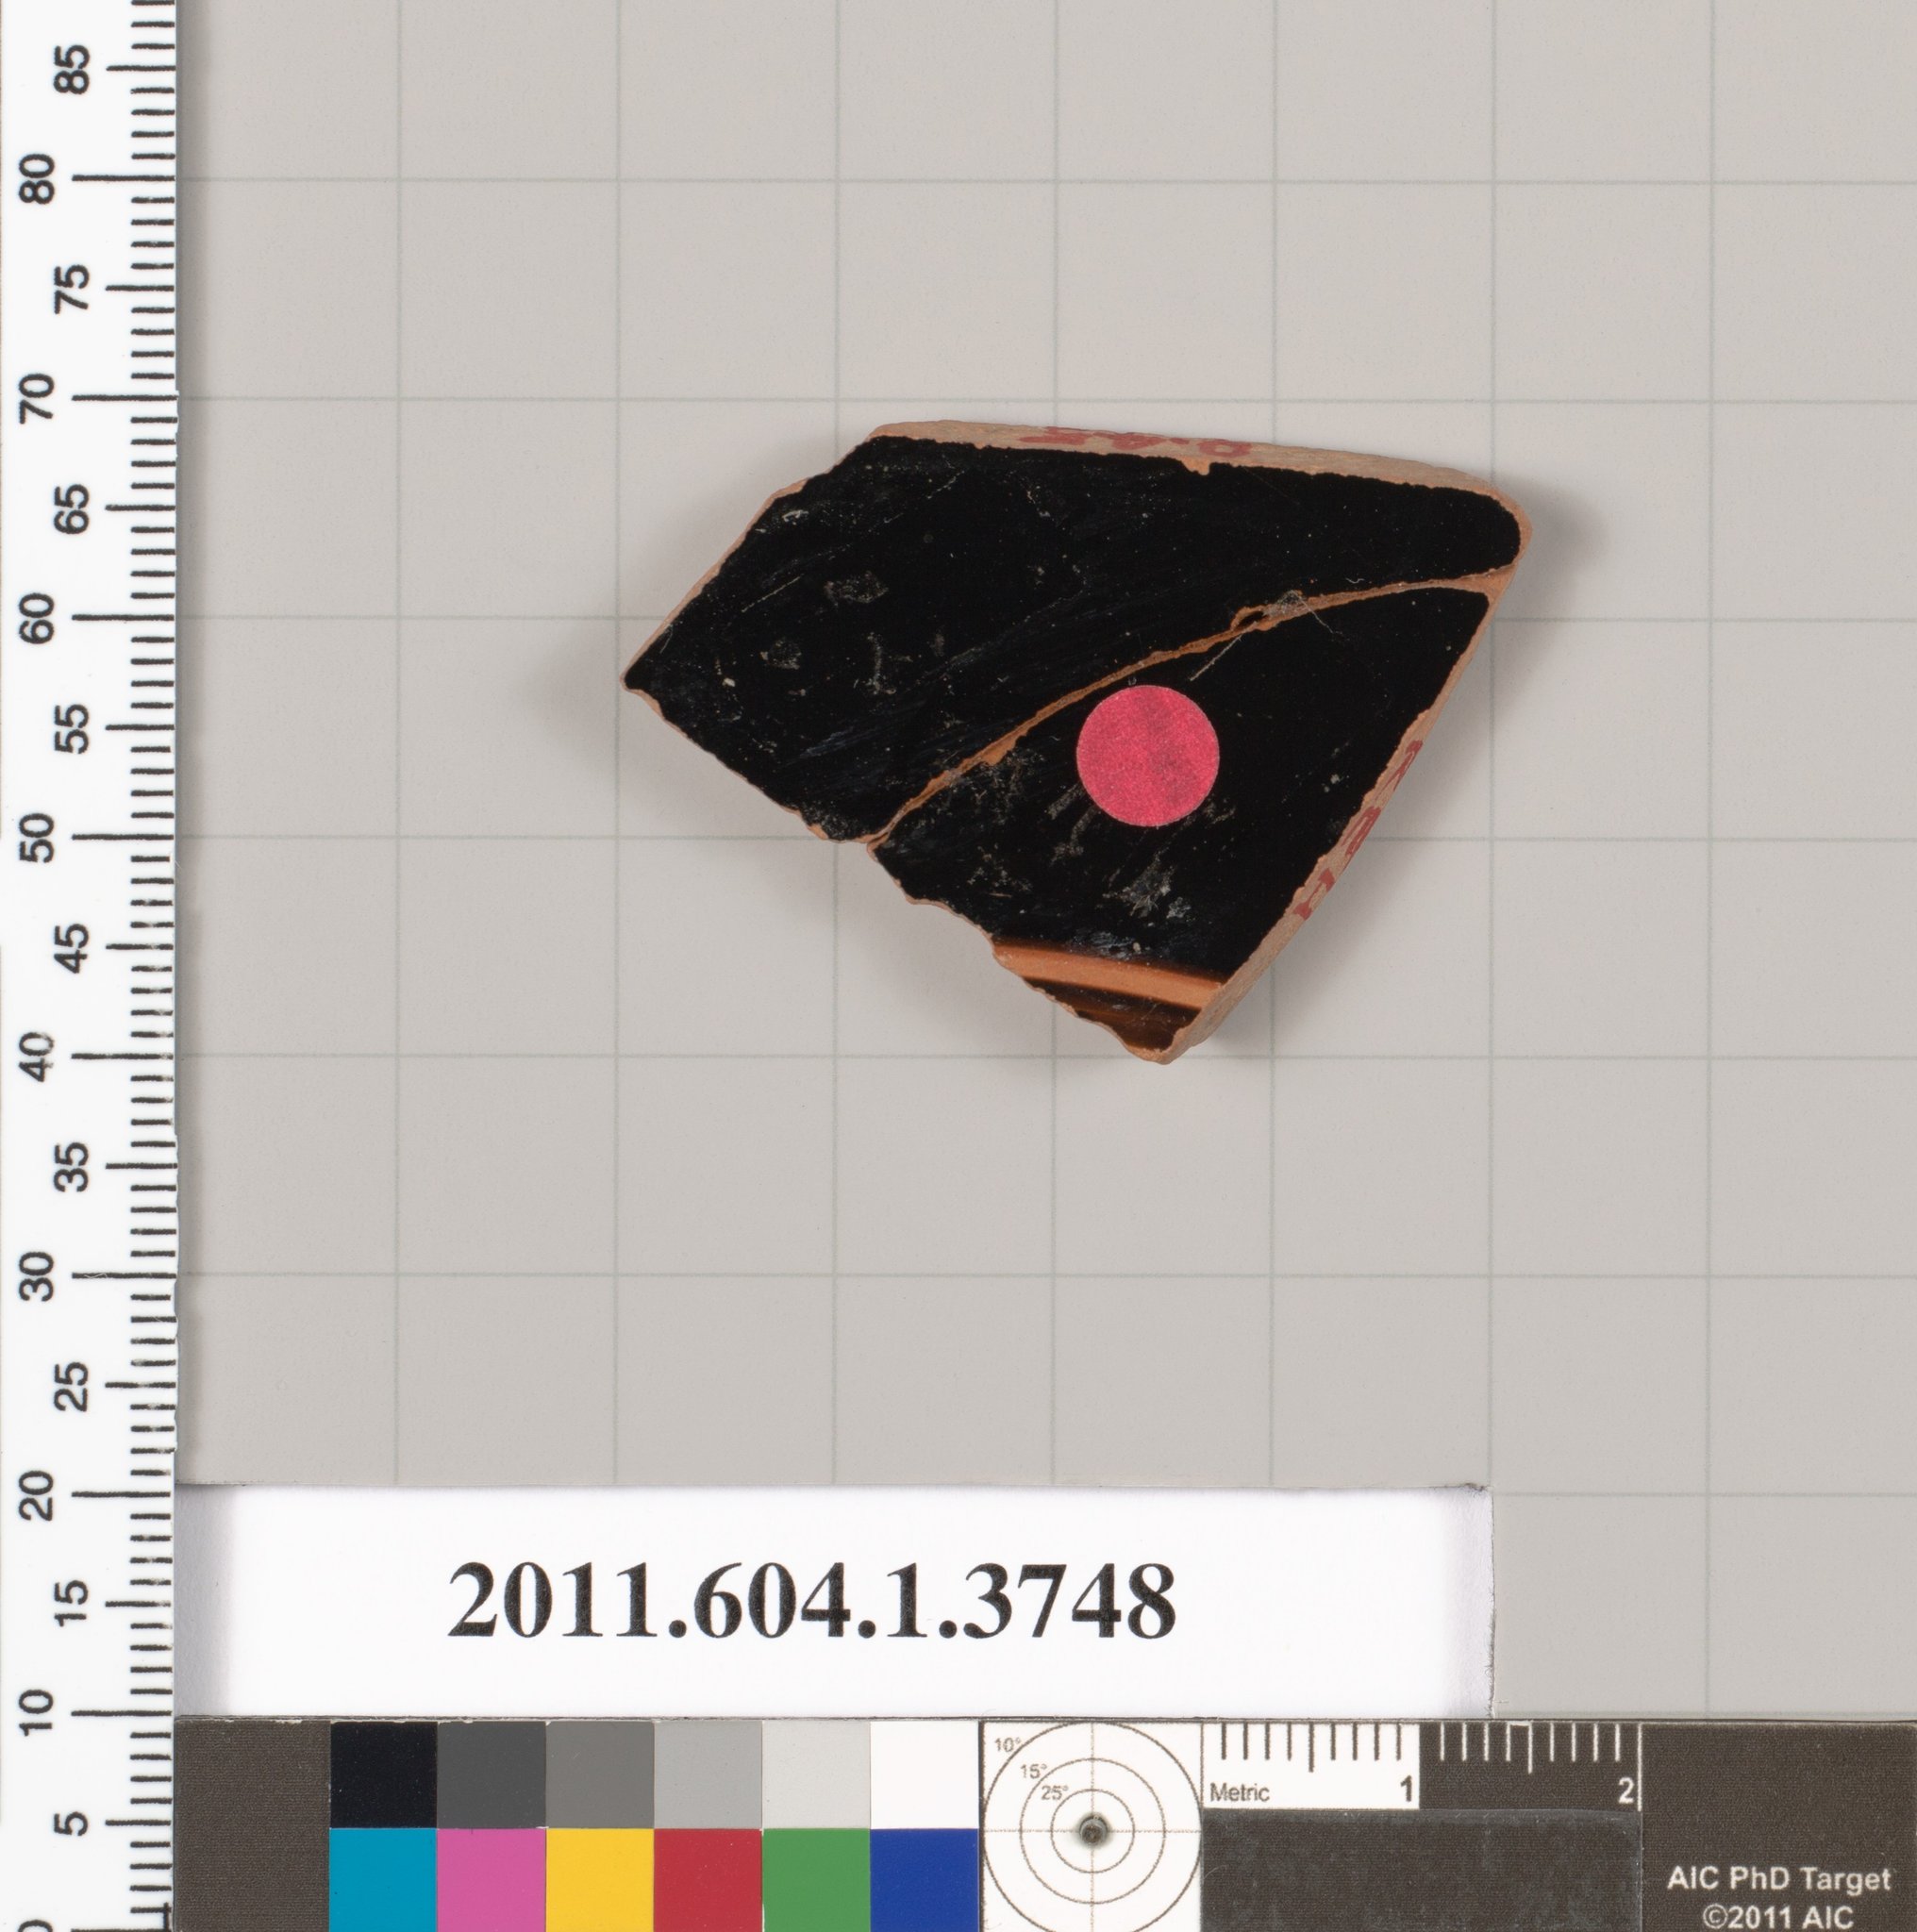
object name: kylix fragment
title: Terracotta fragment of a kylix (drinking cup)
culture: greek, attic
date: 475-451 BCE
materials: terracotta